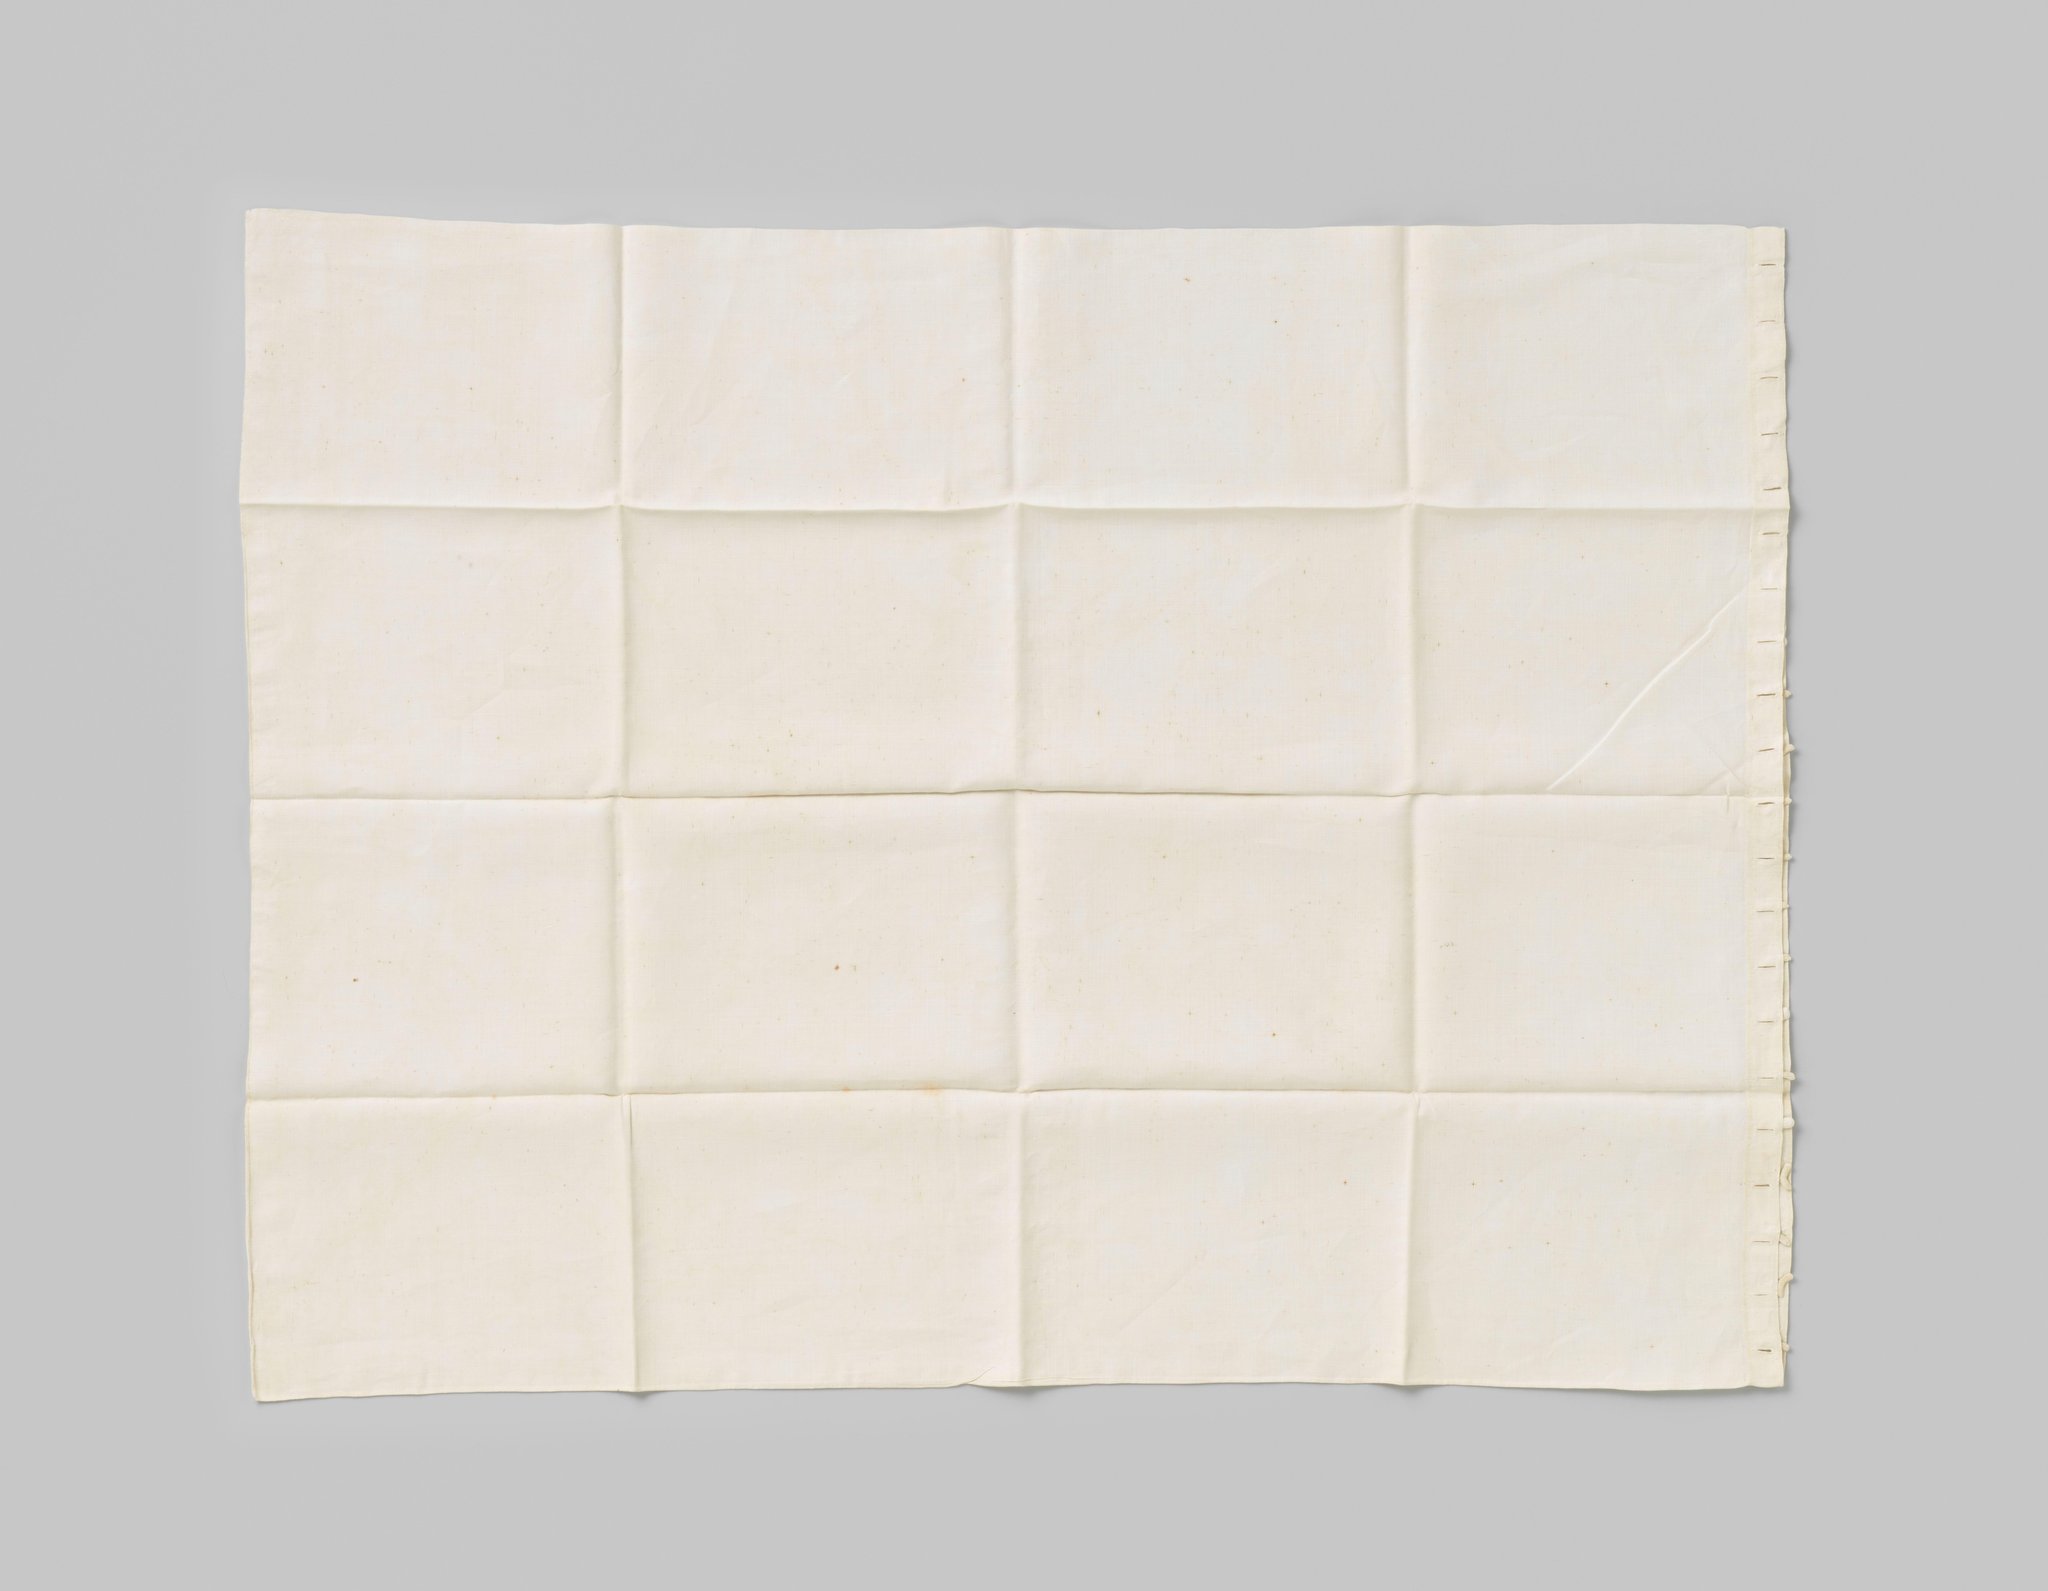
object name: sloop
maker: Anonymous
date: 1700-1799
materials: linen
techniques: weave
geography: netherlands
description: Kussensloop van wit linnen. Bij het sloop hoort een kussensloop met invnr. BK-1980-246-B.